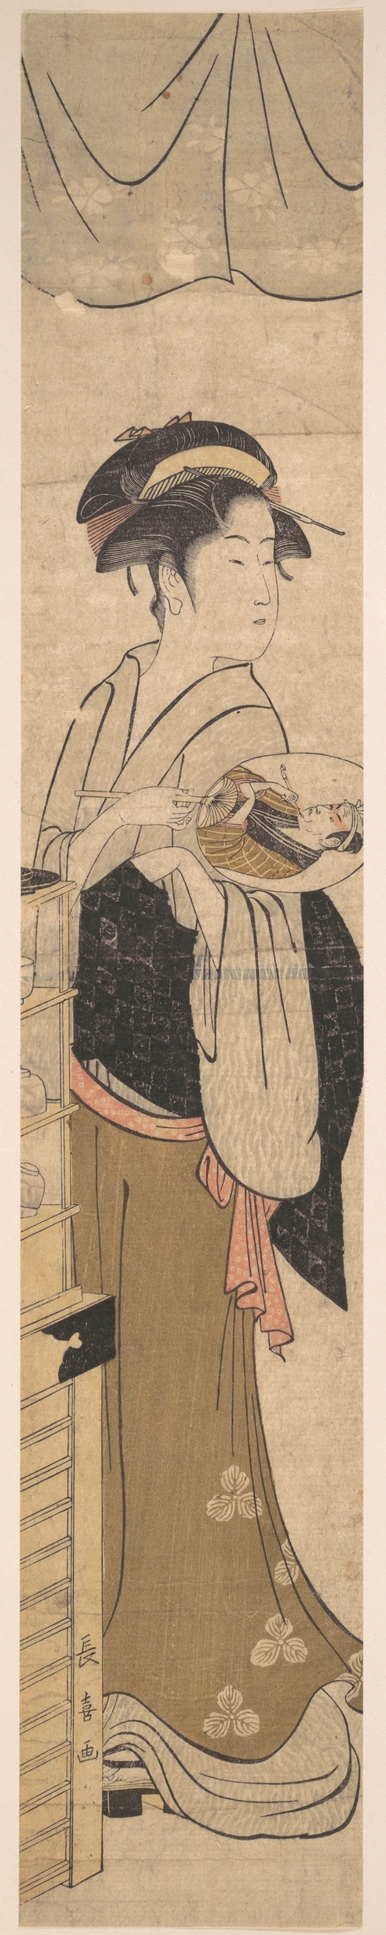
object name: print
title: Young Lady with Fan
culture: japanese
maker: eishōsai chōki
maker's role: artist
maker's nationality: japanese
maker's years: 1700-1900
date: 1771-1835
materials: ink, paper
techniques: woodblock print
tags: fans,women